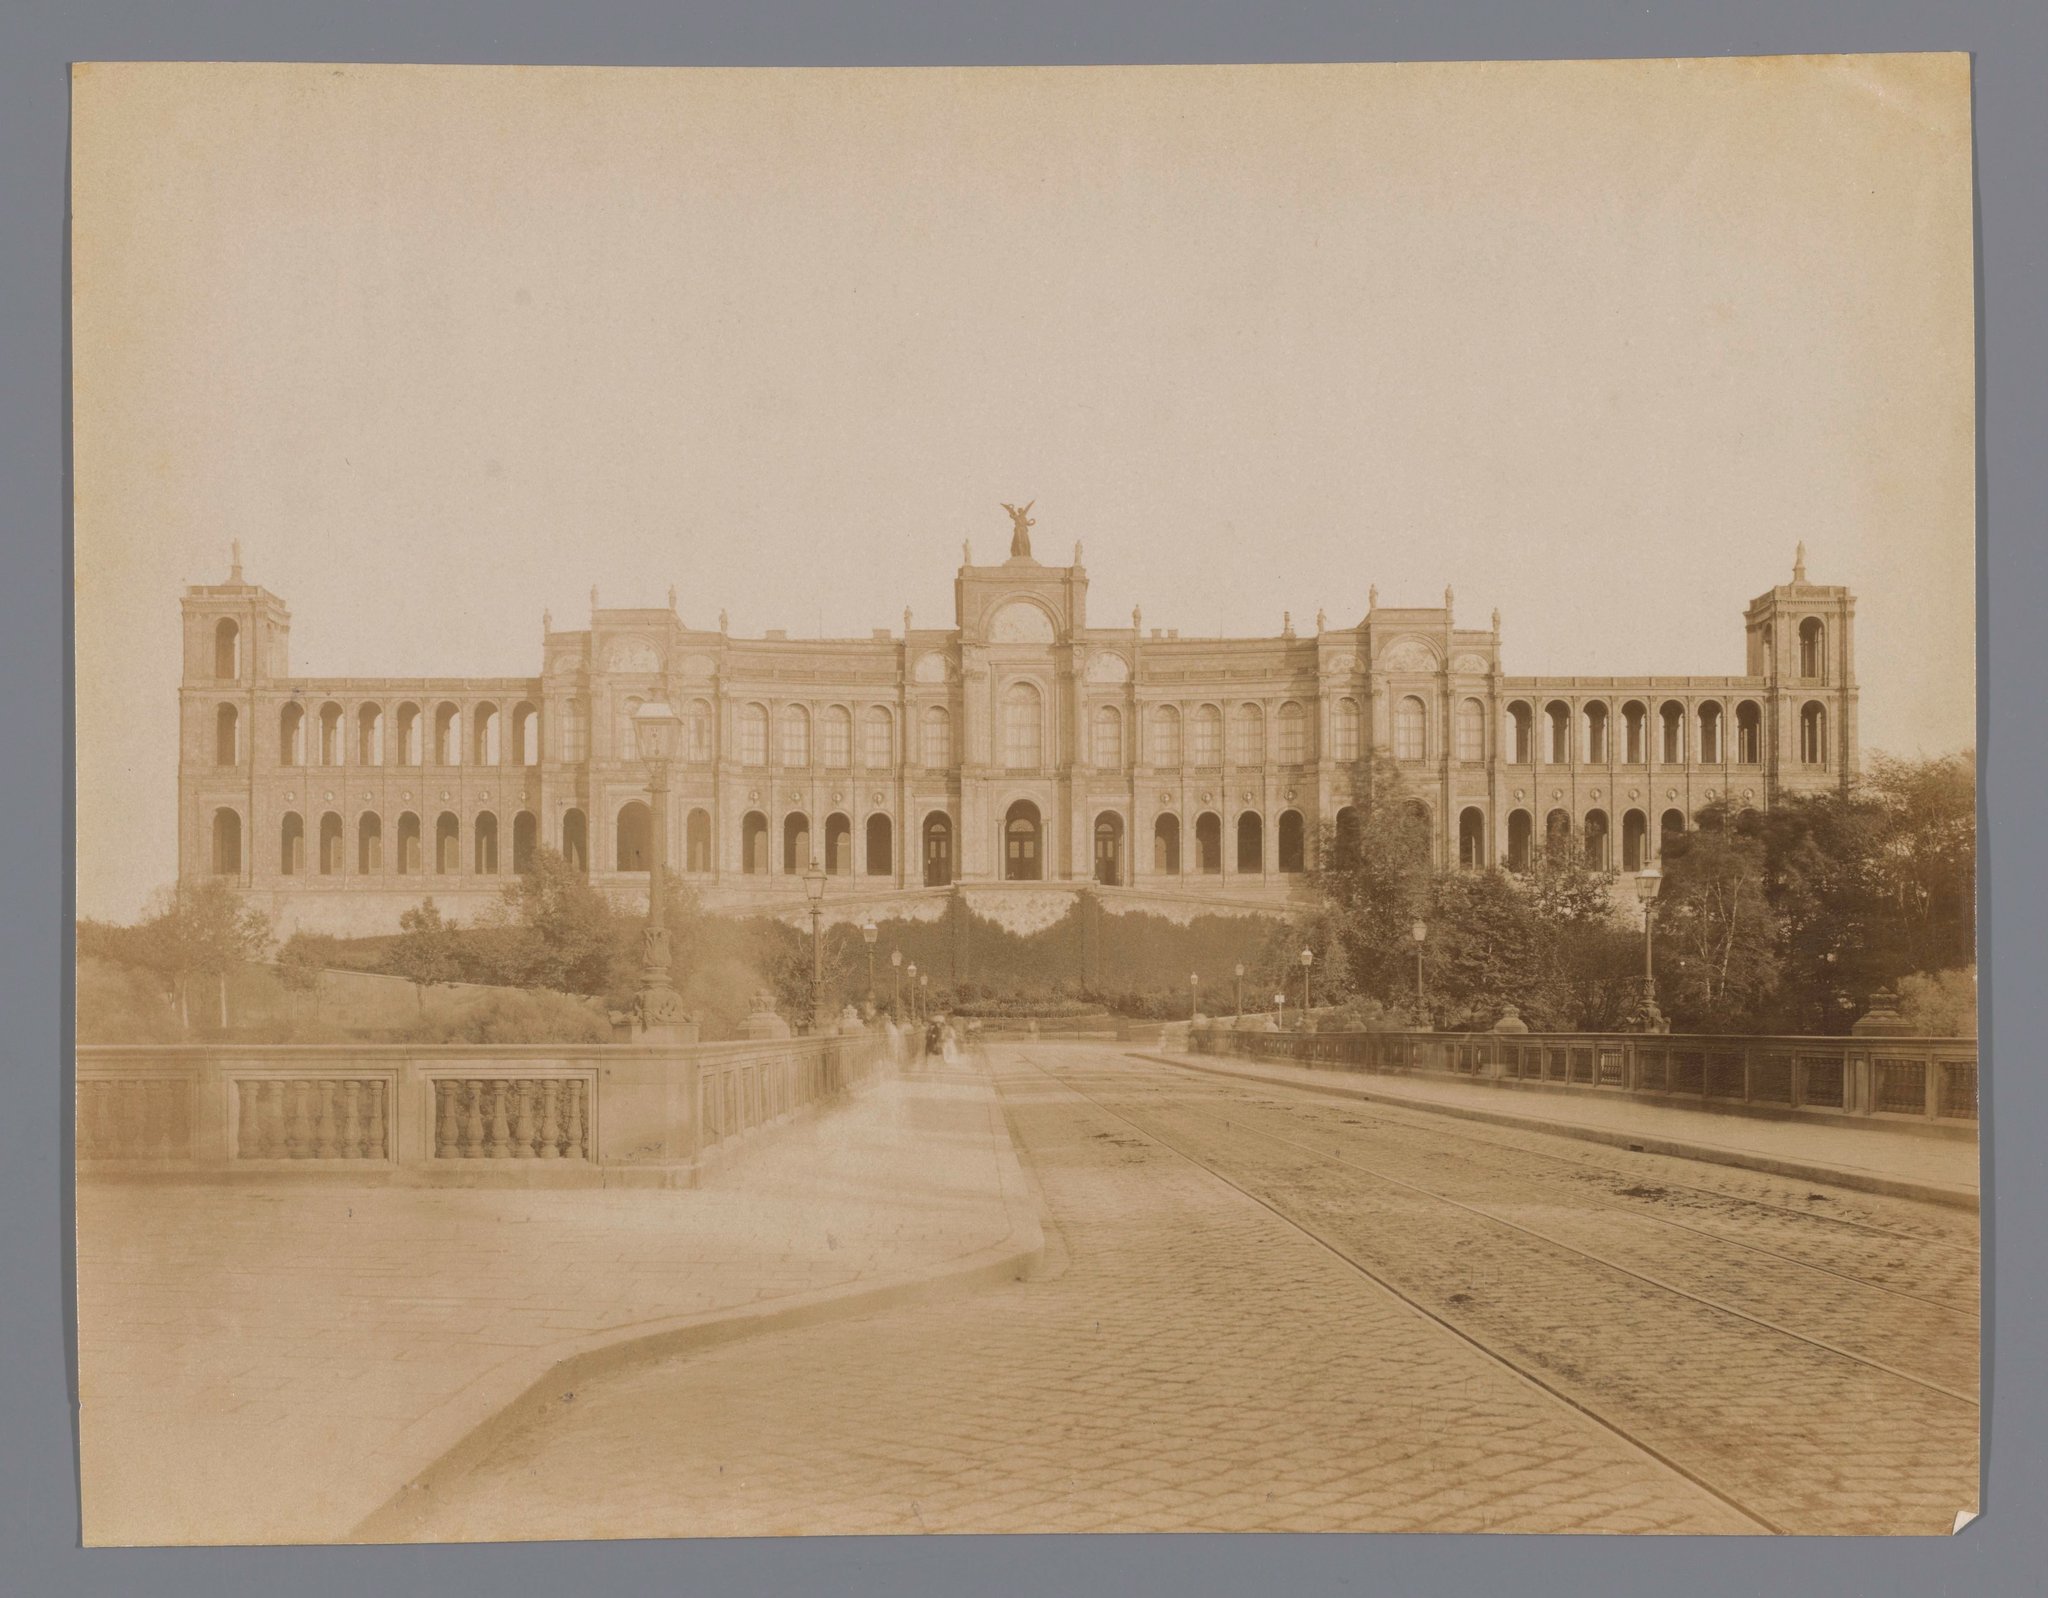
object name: photograph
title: Gezicht op het Maximilianeum in München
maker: Anonymous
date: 1876-1910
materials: paper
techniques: albumen print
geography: munich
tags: edifice, e.g.: public building, department store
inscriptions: inscription: ‘München Maximilianeum’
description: Gezicht op het Maximilianeum in München, gezien vanaf de Isarbrücke.